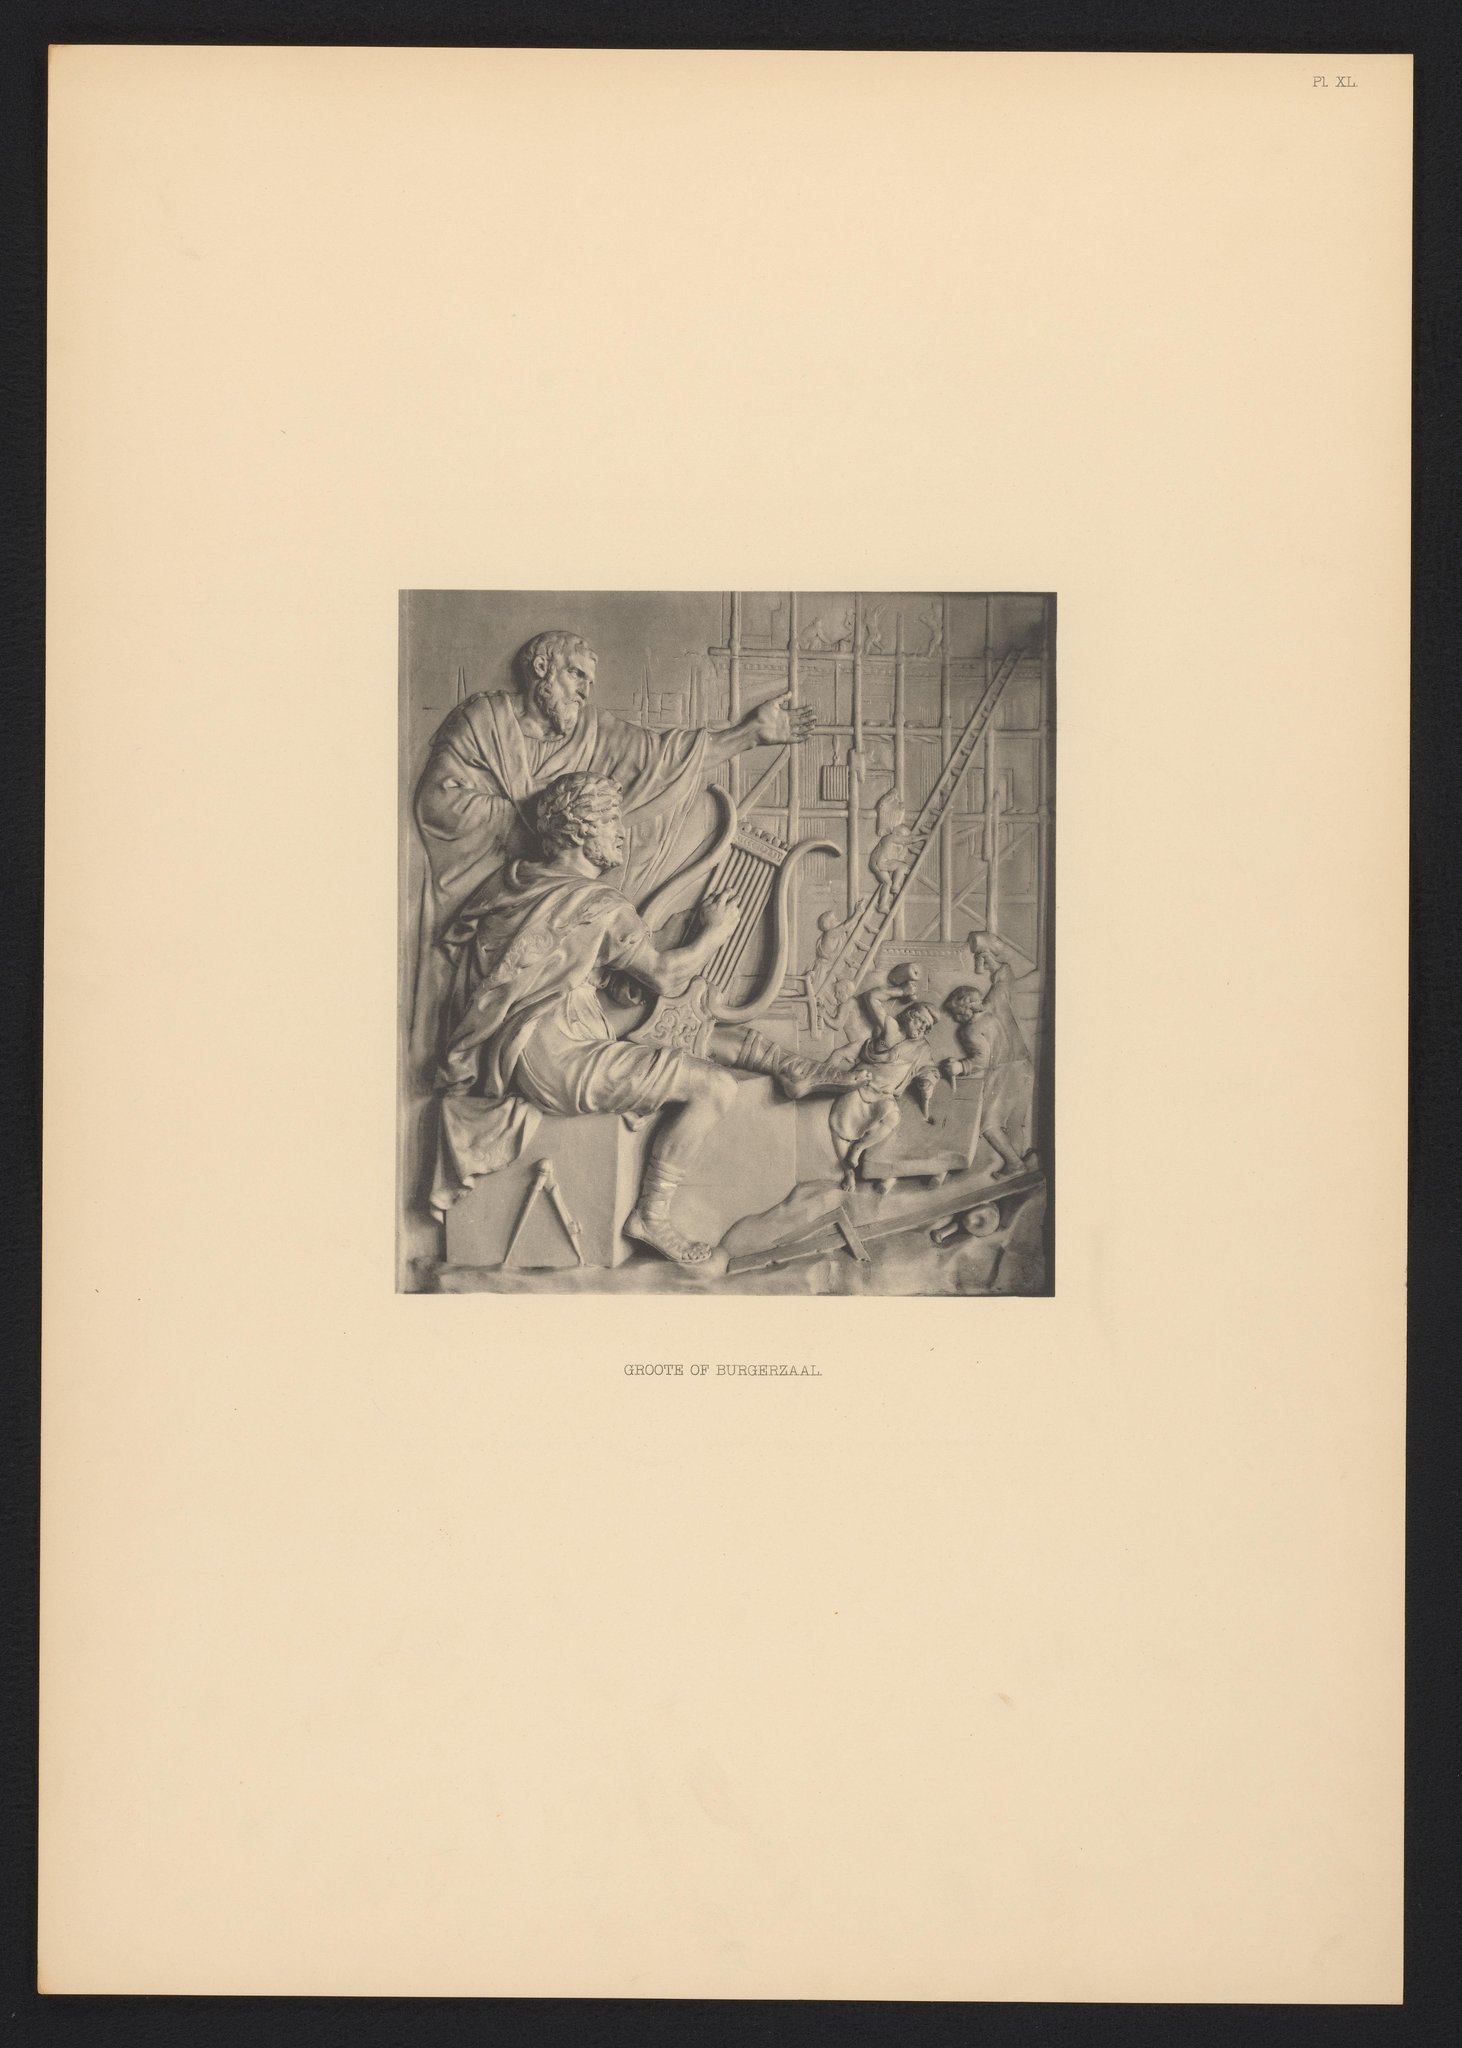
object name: fotomechanisch procedé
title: C.T.J. Louis Rieber, Het Koninklijk Paleis te Amsterdam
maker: Anonymous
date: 1899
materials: cardboard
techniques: photograph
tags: palace, piece of sculpture, reproduction of a piece of sculpture, interior of the house, royal palace of amsterdam, amsterdam